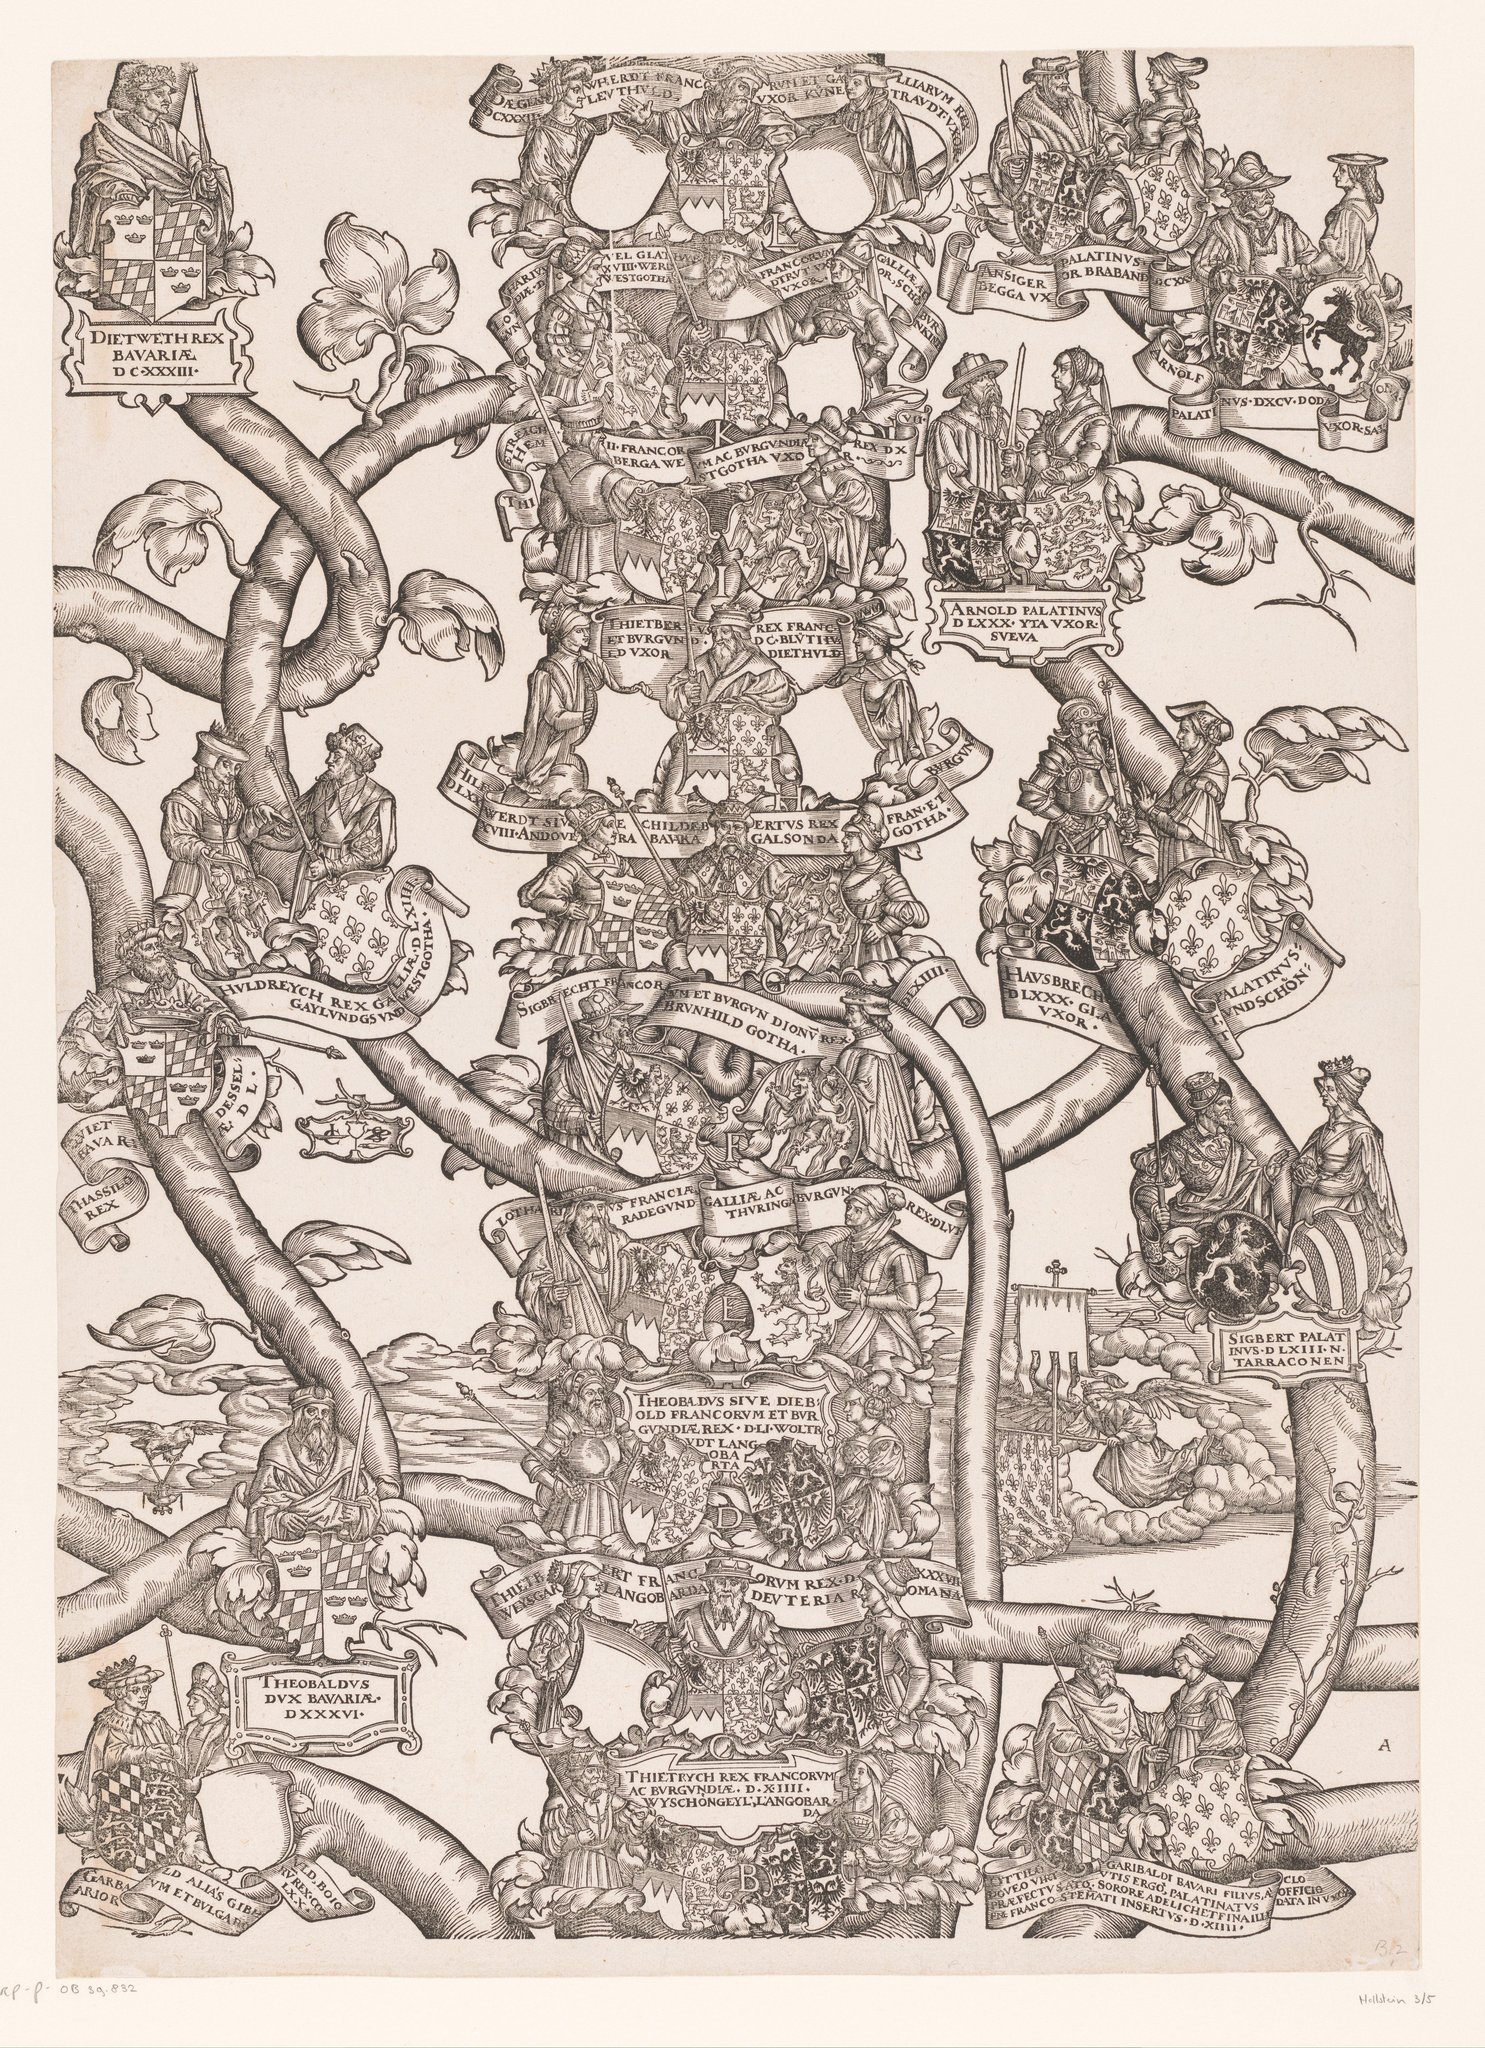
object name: print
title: Stamboom van Frederik en Ottheinrich van Palts-Neuburg (plaat 5)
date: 1535-1594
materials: paper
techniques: letterpress printing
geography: basel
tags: amberg, earl, family lineage, pedigree, genealogical tree or table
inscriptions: collector's mark: Lugt 240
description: Blad 5 van een stamboom bestaande uit 21 bladen, gedrukt van 42 blokken.